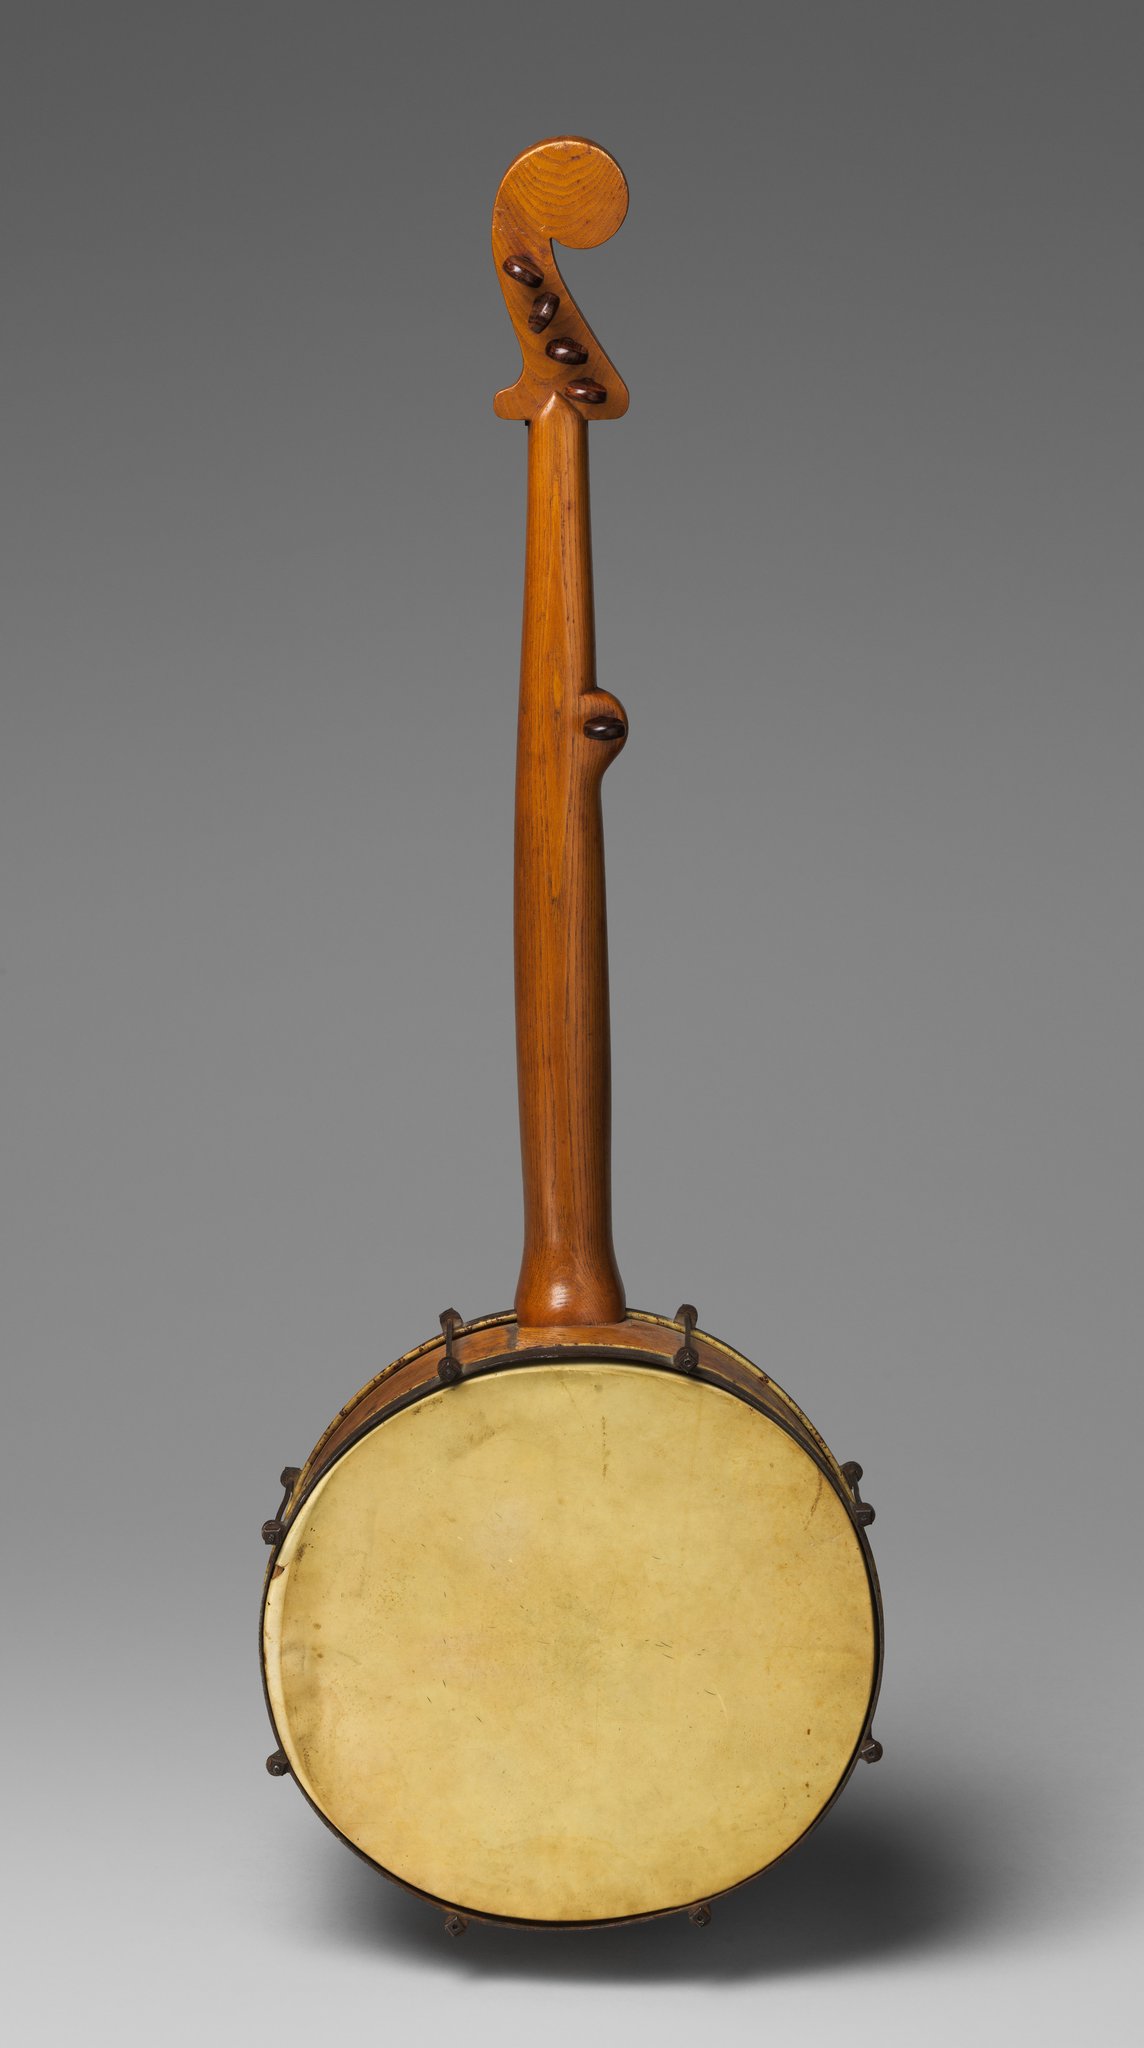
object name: double head fretless banjo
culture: american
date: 1850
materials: leather, metal, wood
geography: united states